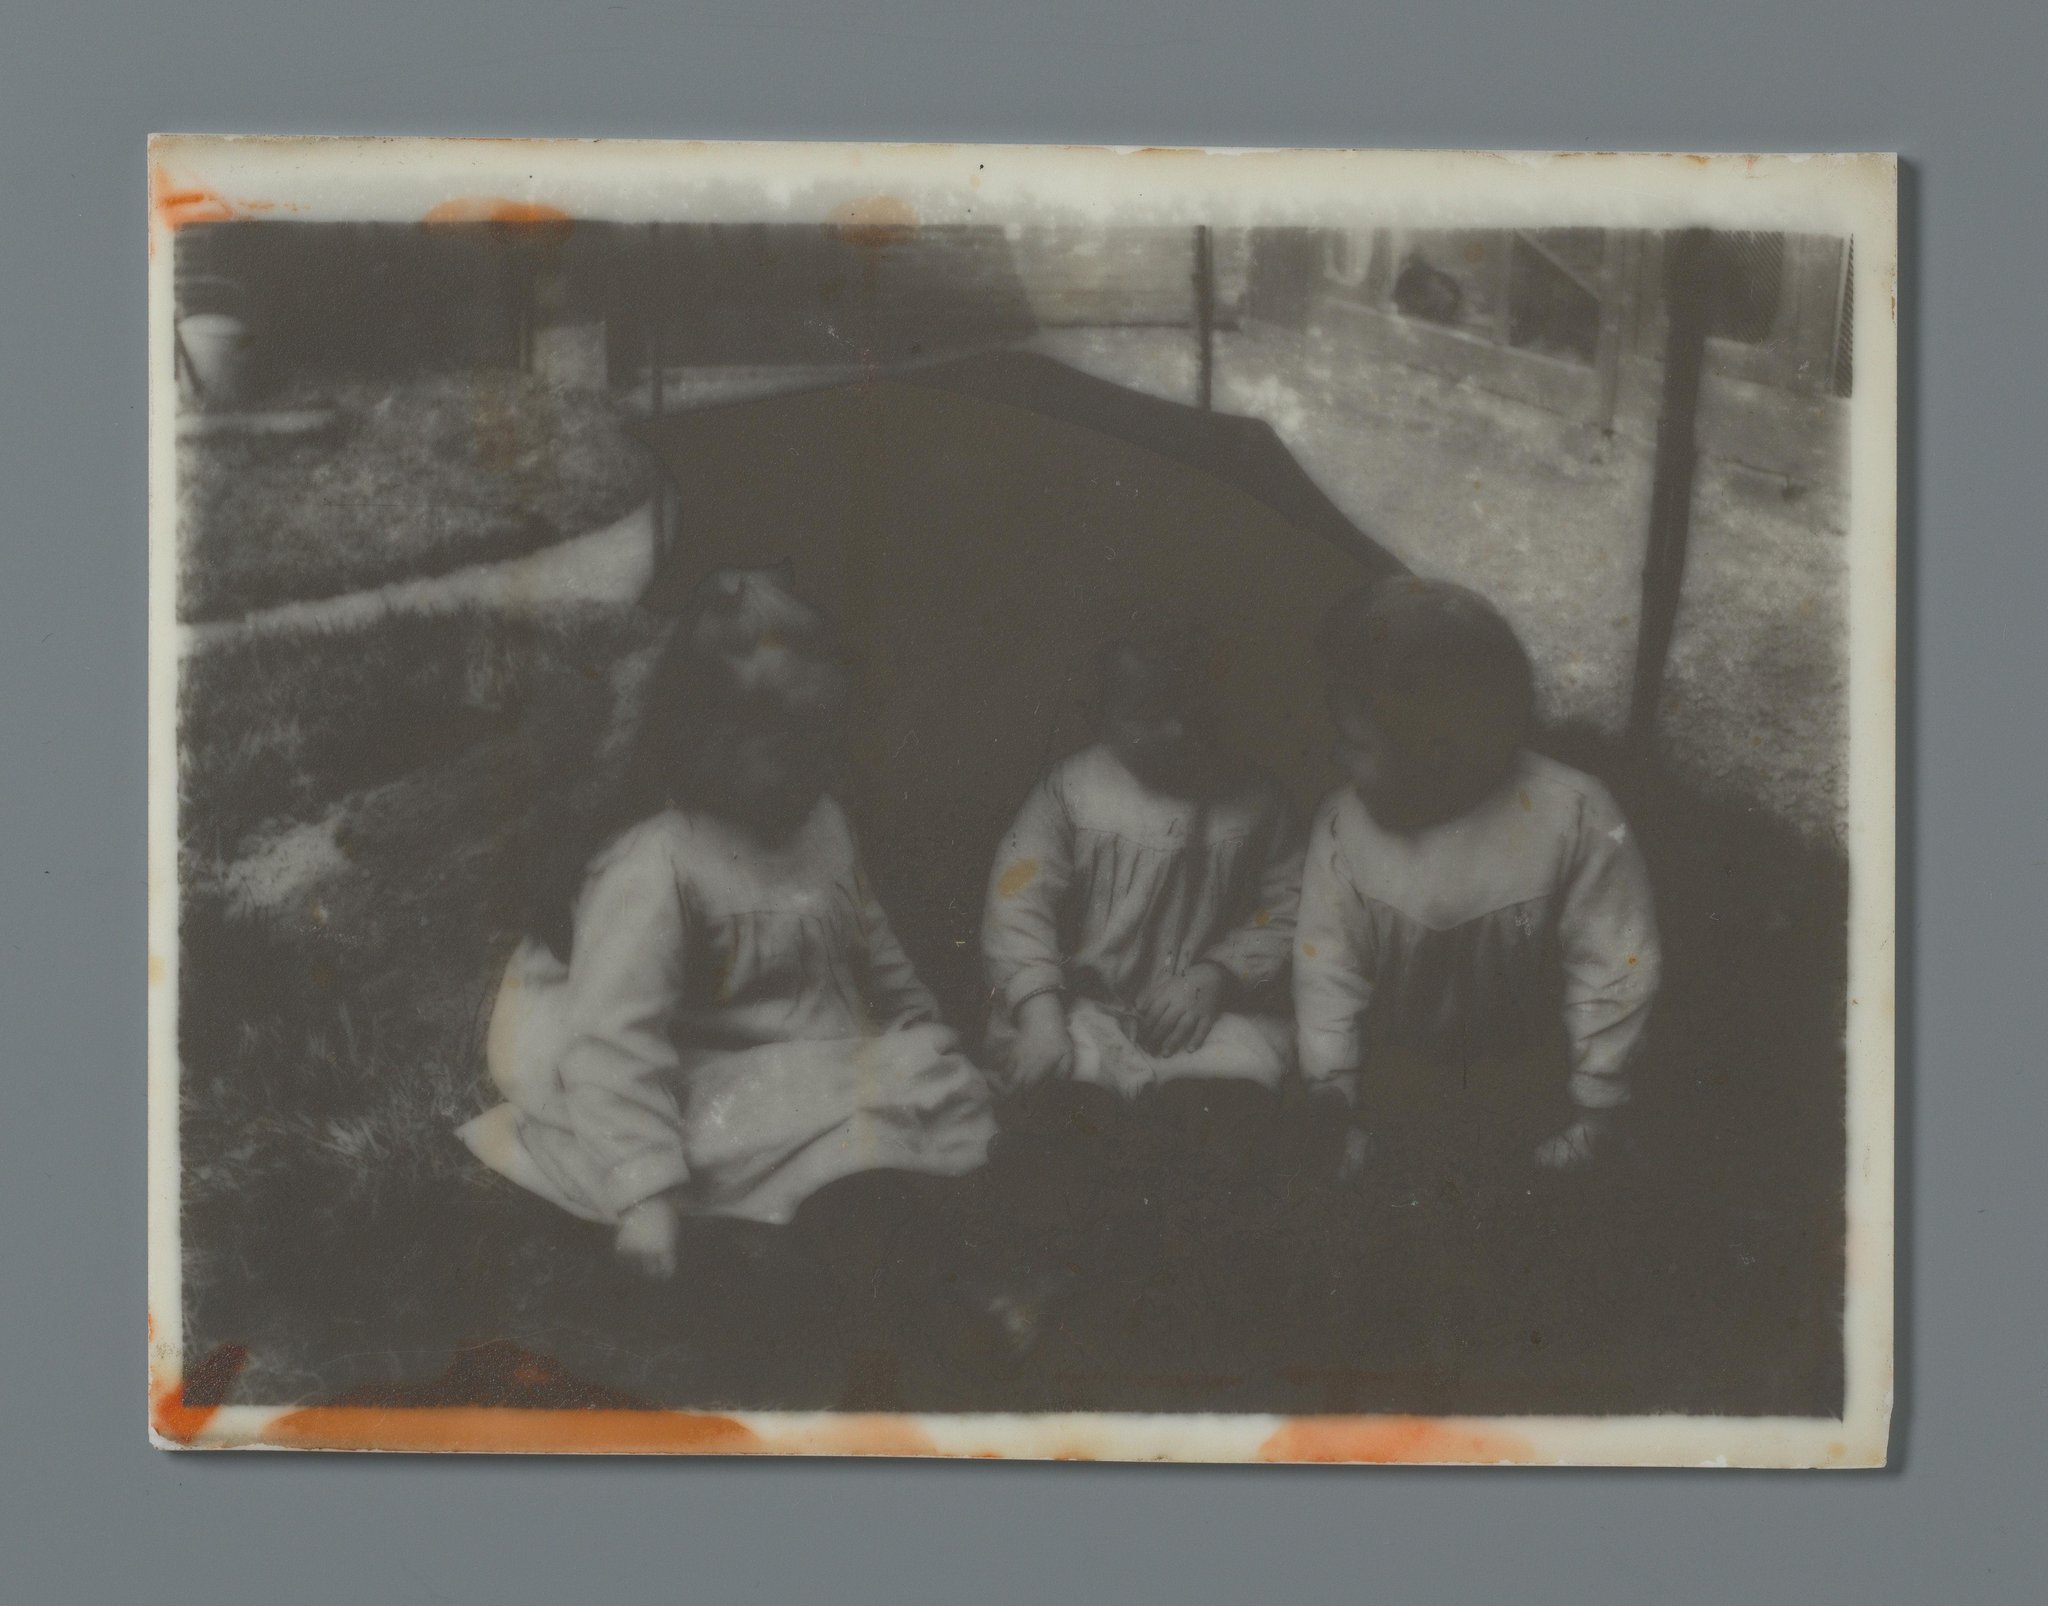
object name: photograph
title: Drie kleuters in een tuin zittend onder een paraplu, waarschijnlijk de tweeling Ad (rechts) en Johanna (links) en Han (midden) van der Kop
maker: willem carel van der kop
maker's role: amateurfotograaf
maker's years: 1869-1924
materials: glass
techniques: gelatin silver print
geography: schoonhoven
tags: sculptor, adrianus johannes van der kop (ad), amsterdam, painter, draughtsman, umbrella, tot, toddler ~ the ages of man